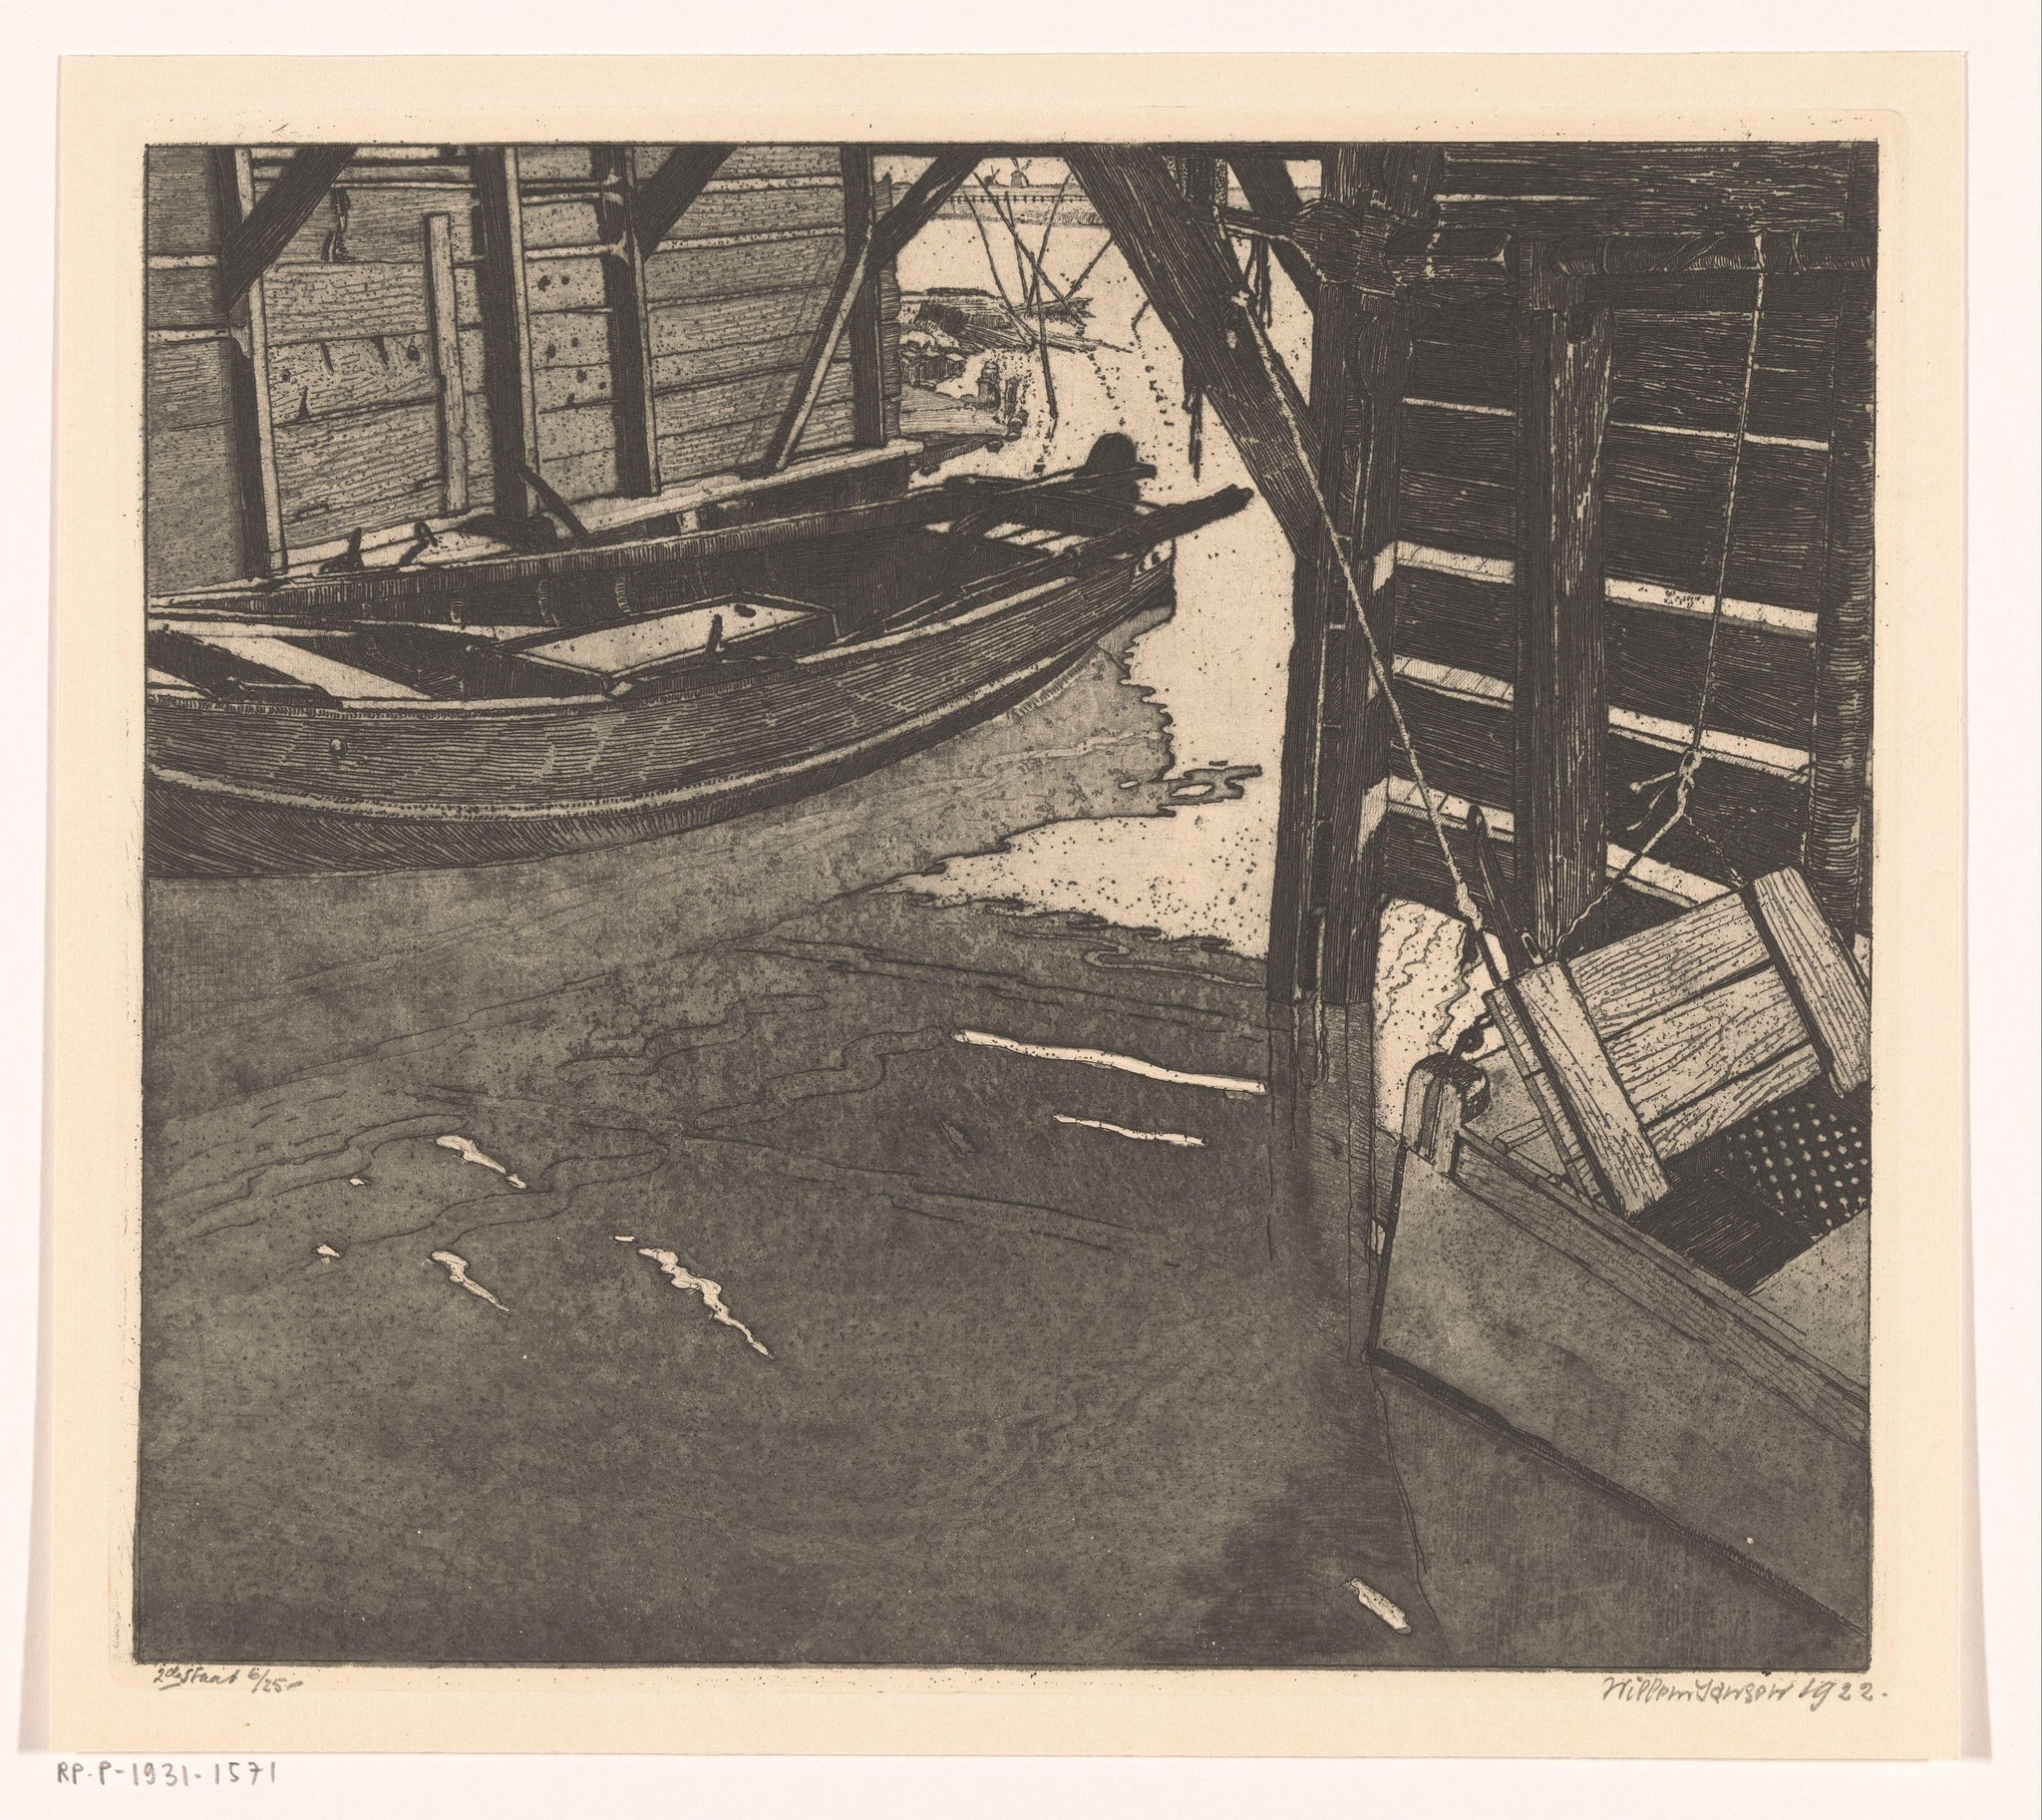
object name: print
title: Interieur van een schuitenhuis met een viskaar en een schuit met ingebouwde viskaar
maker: willem jansen (graveur)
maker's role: print maker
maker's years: 1892-1969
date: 1922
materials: paper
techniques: etching, intaglio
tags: rowing-boat, canoe, etc., boat-house, shed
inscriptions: collector's mark: Lugt 2228